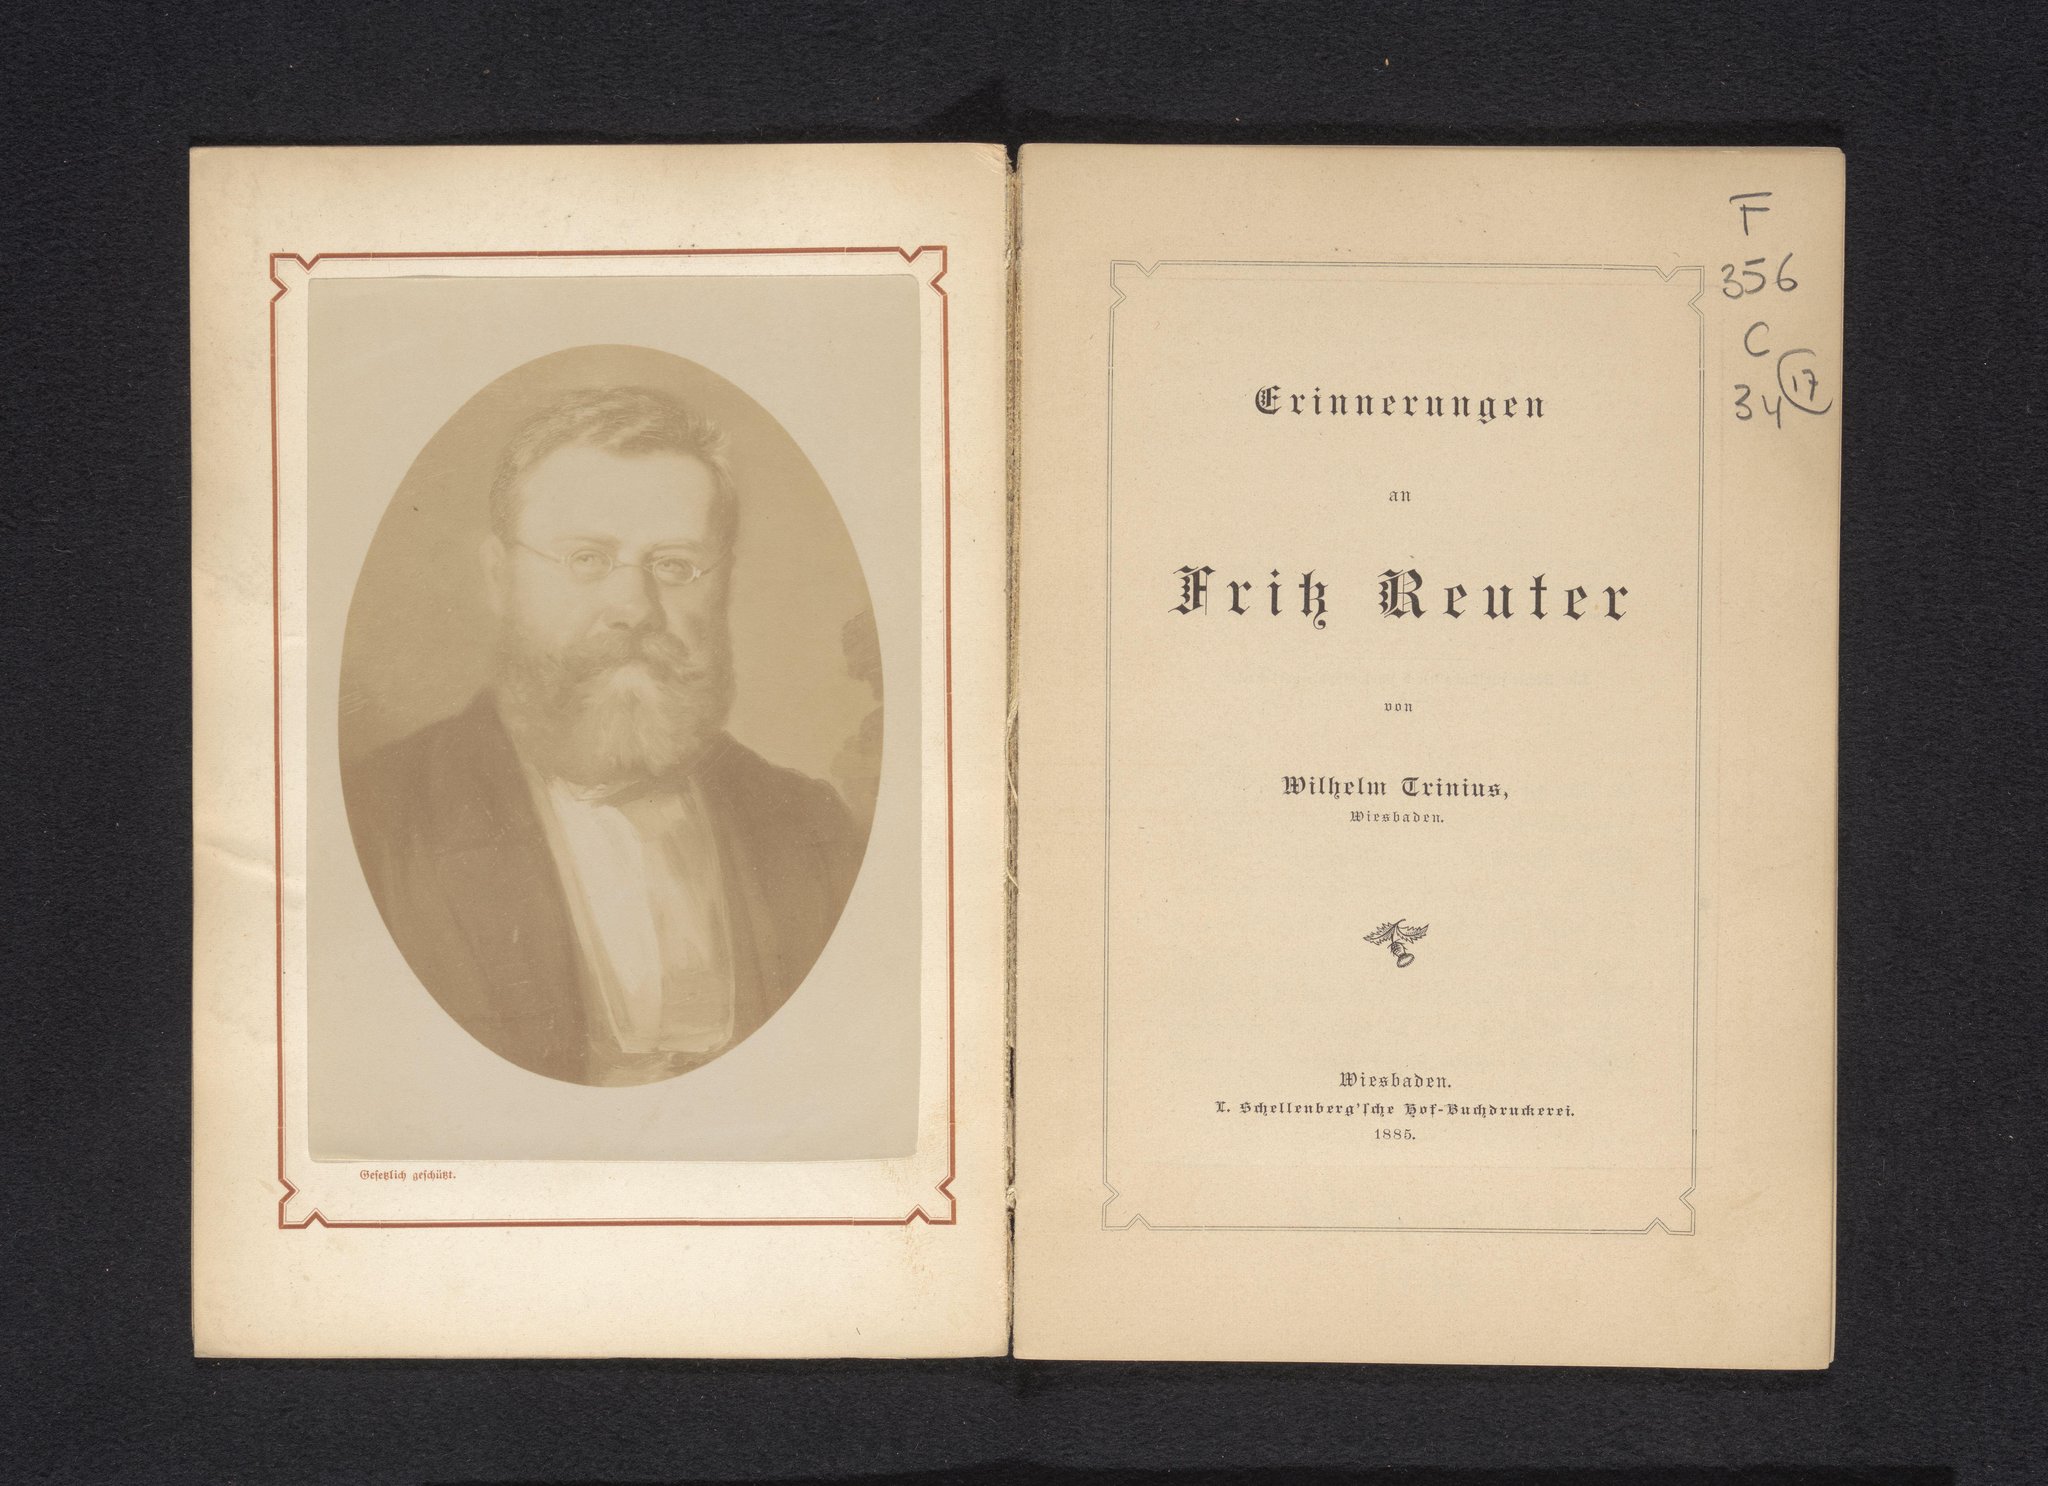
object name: book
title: Erinnerungen an Fritz Reuter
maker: wilhelm trinius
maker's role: schrijver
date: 1885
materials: paper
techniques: albumen print, printing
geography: wiesbaden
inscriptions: inscription: ‘ex -N 1993’